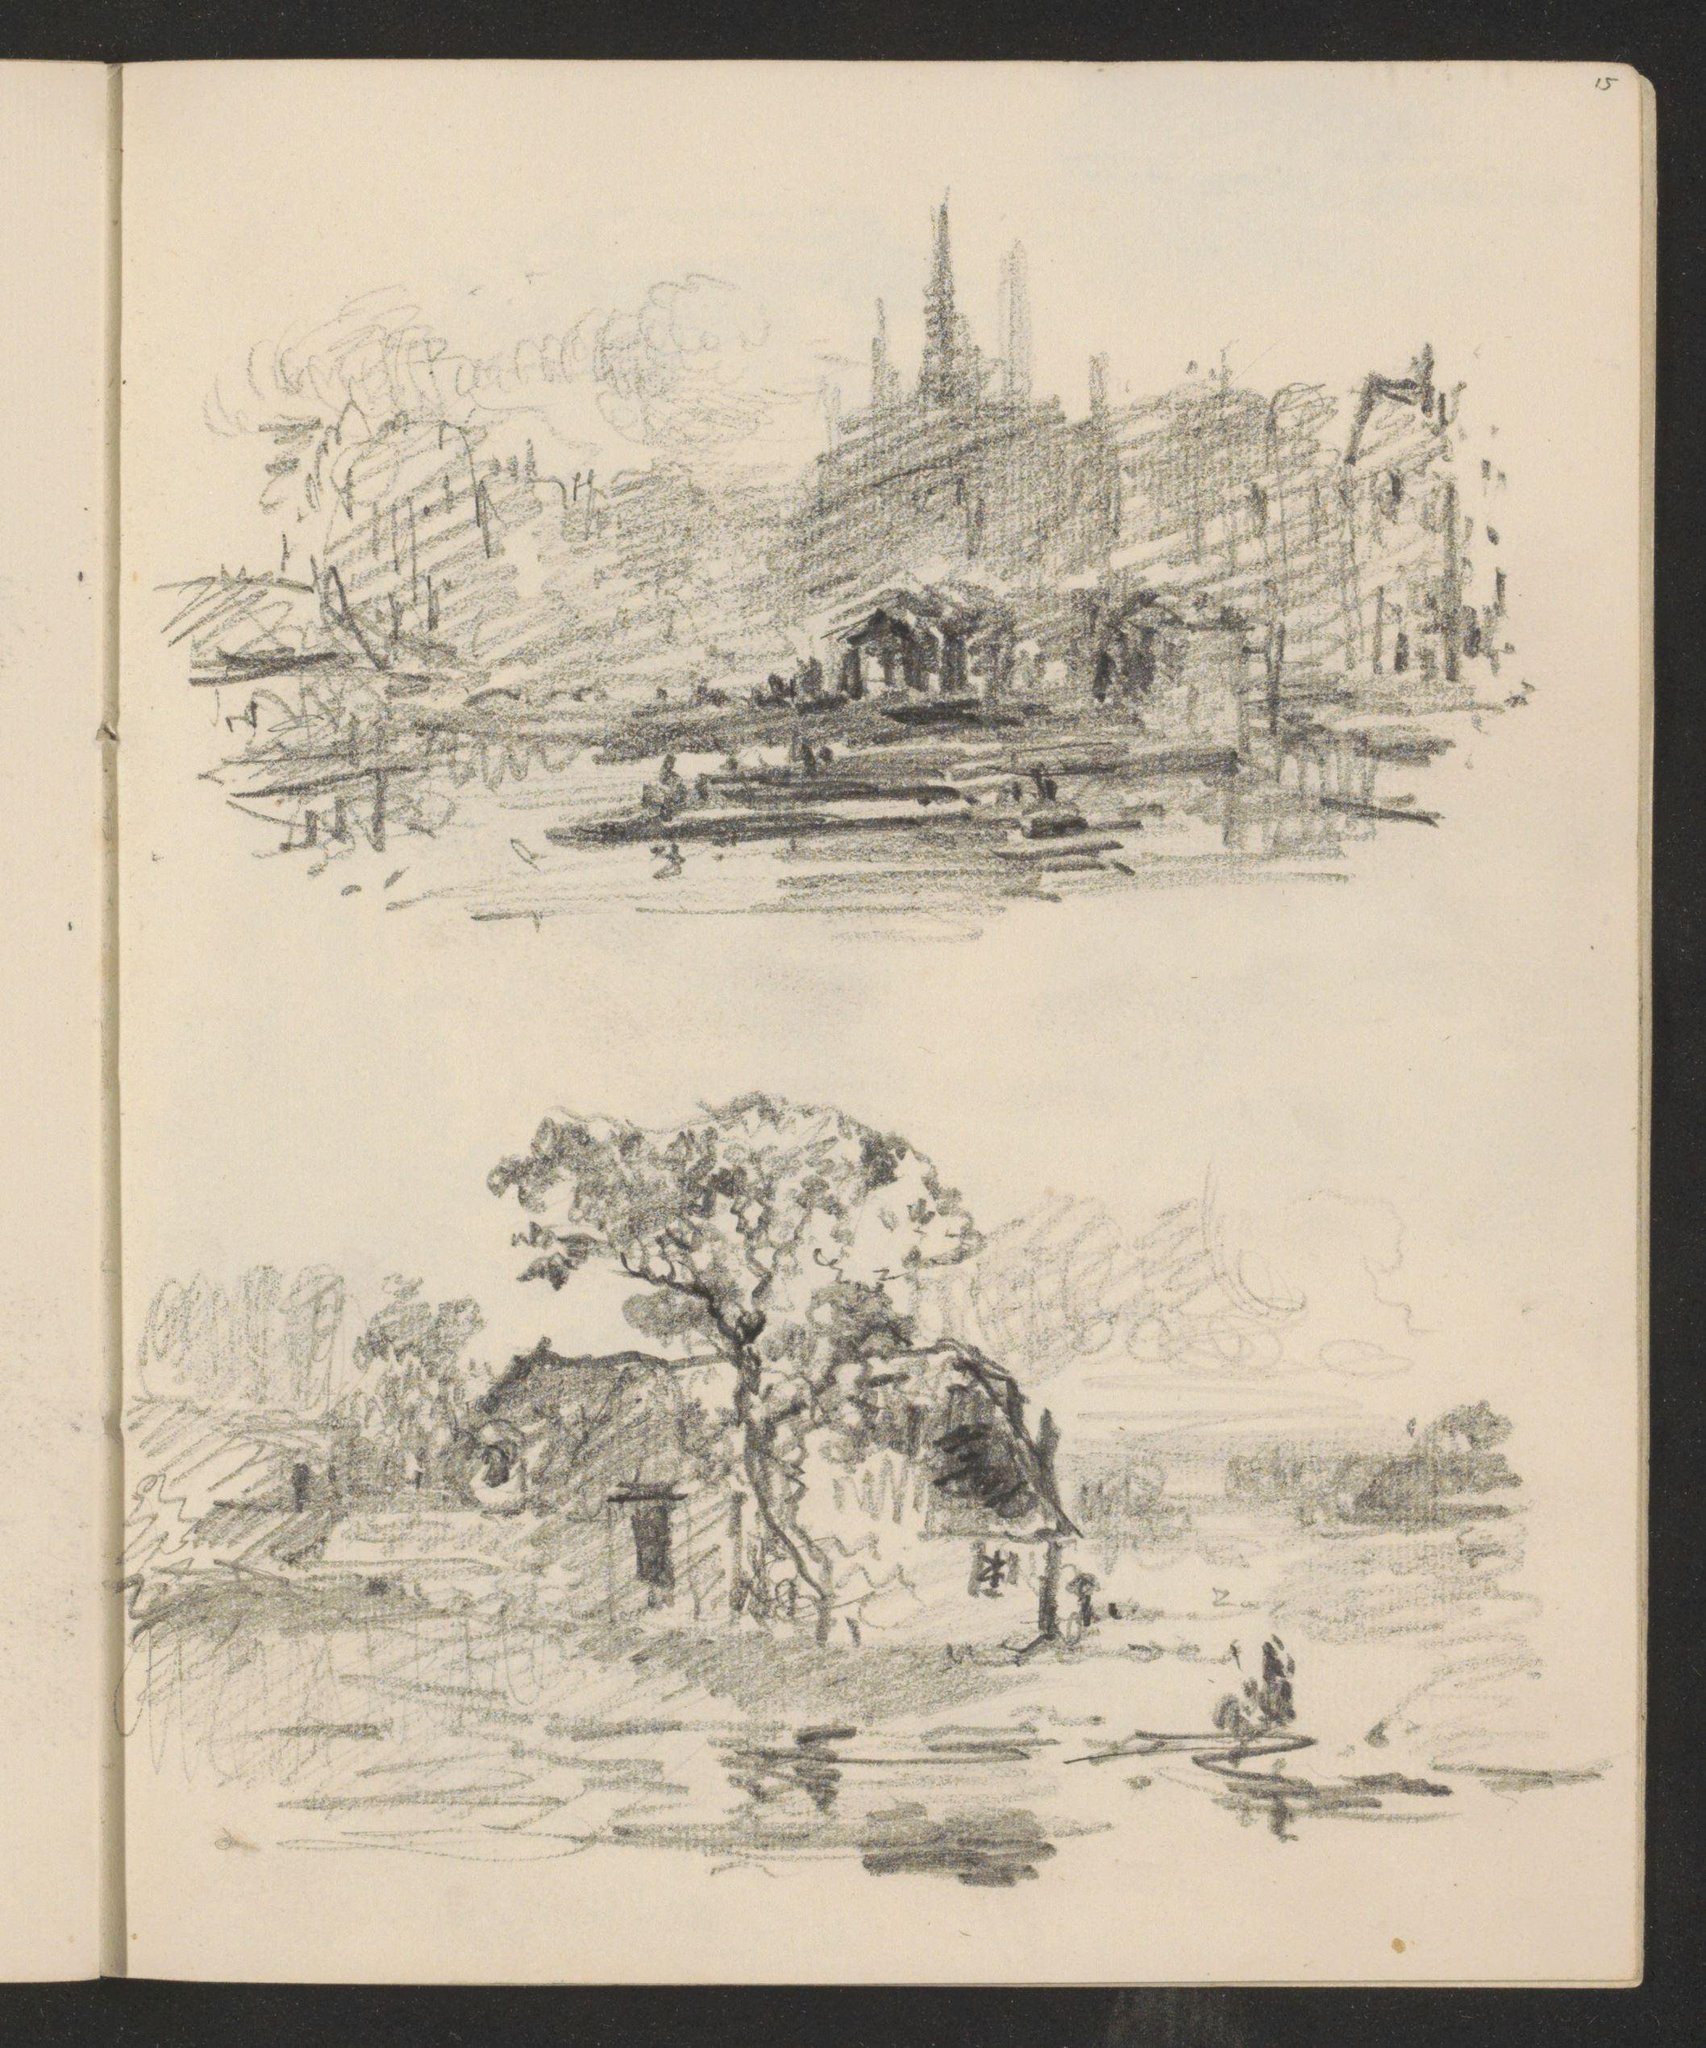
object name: sketchbook leaf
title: Stadsgezicht en een landschap met een huis aan het water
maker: maria vos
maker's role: draughtsman, painter, print maker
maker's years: 1824-1906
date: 1858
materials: paper, pencil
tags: city-view, and landscape with man-made constructions, rural housing, e.g. country-house, villa, cottage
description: Blad 15 recto uit een schetsboek met 19 bladen.